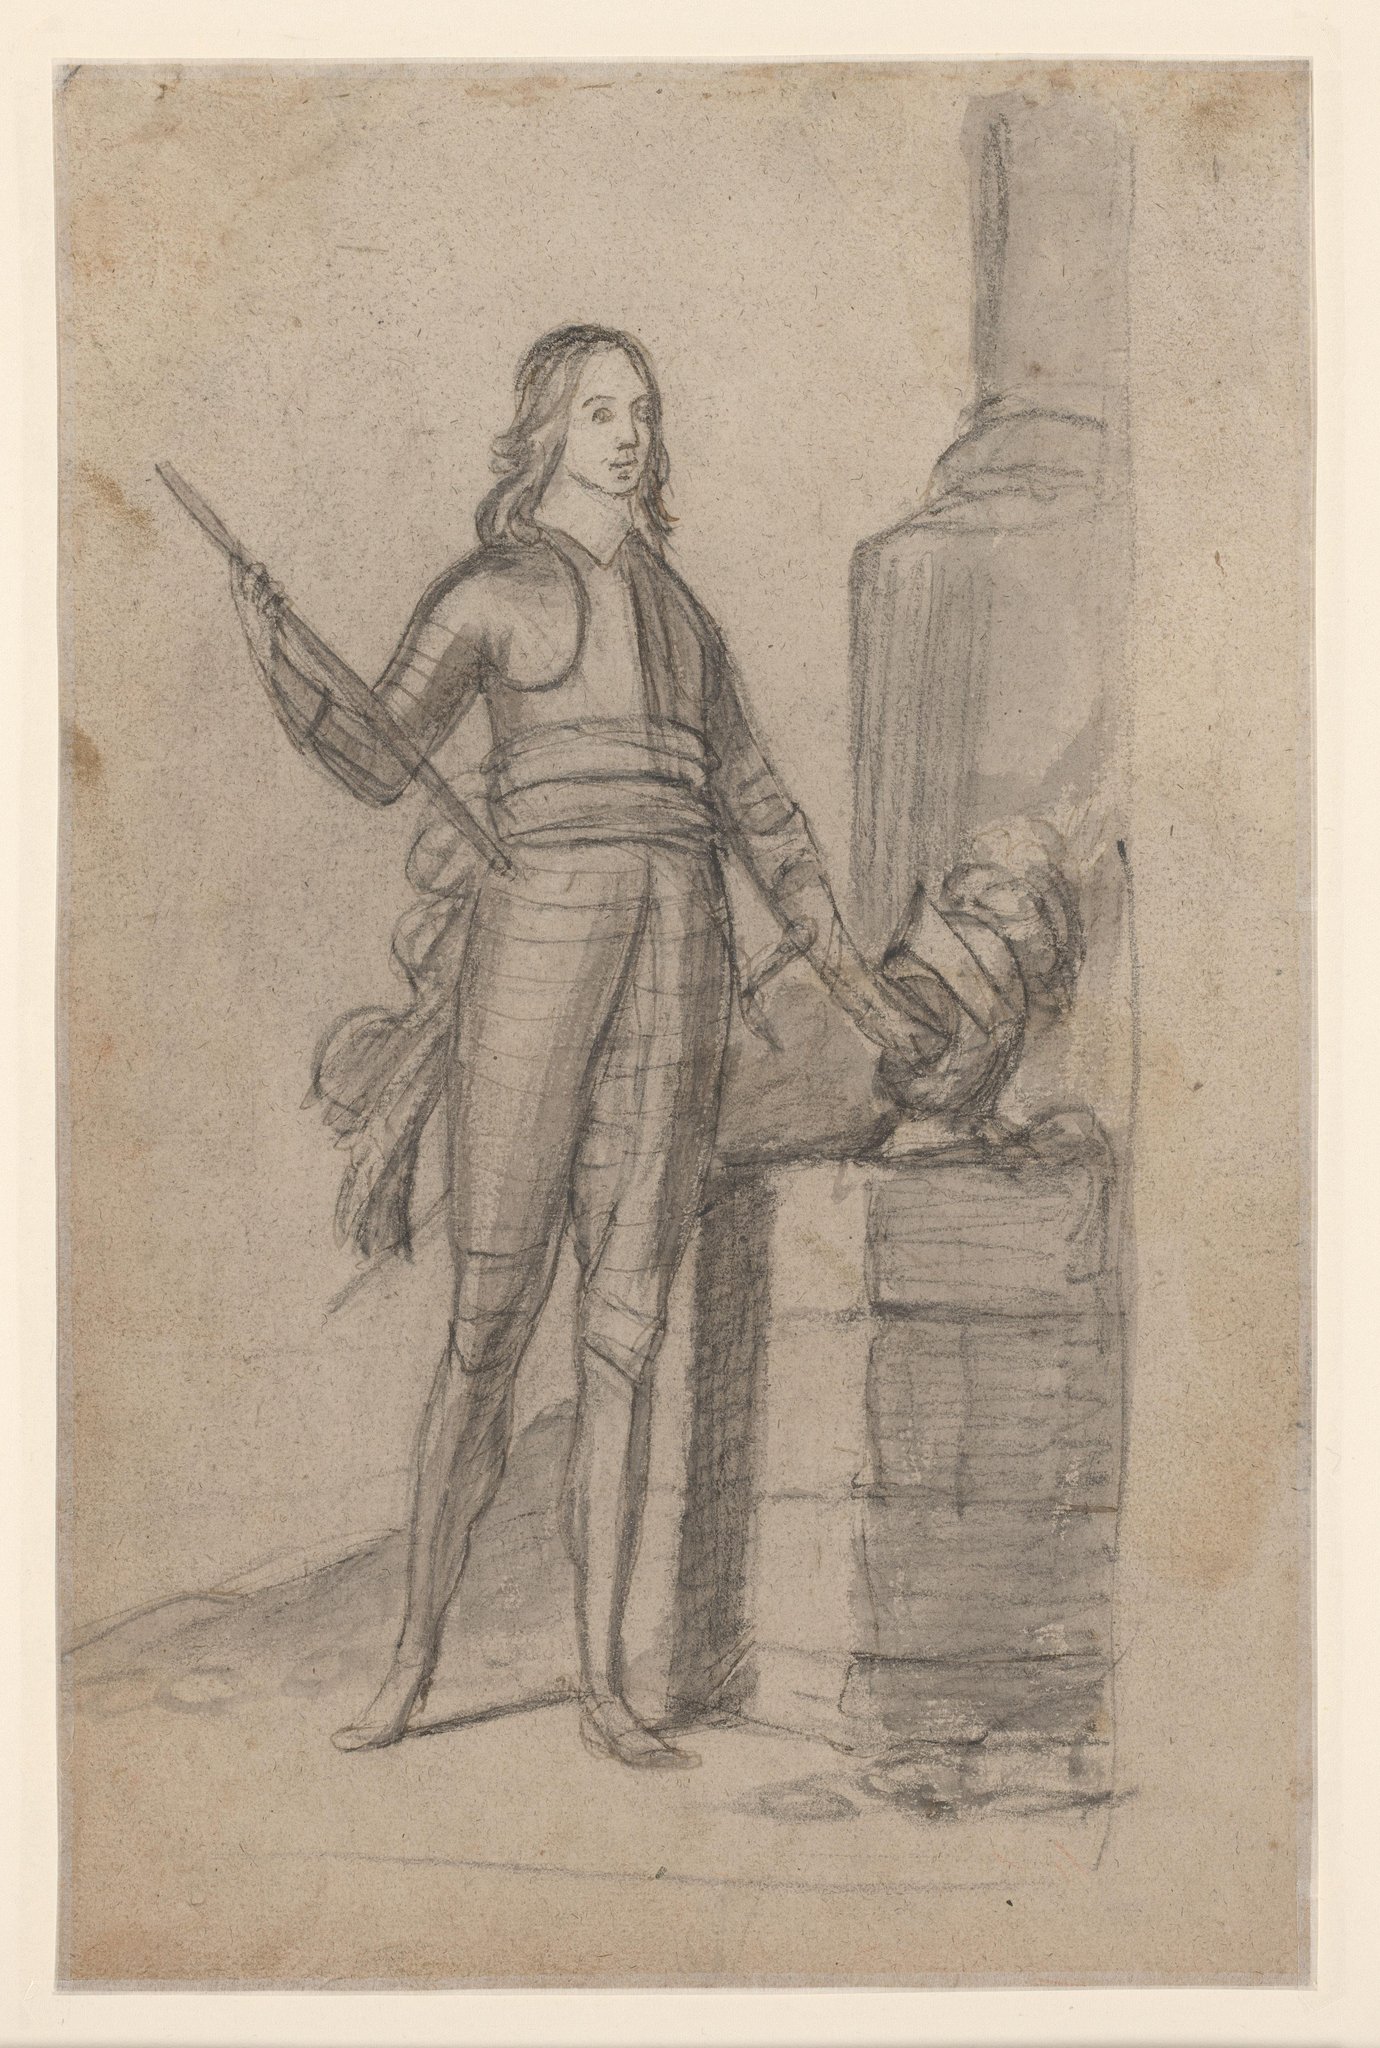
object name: drawing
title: Staande man in harnas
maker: gerard van honthorst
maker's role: draughtsman, painter, print maker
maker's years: 1592-1656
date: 1625-1655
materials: paper, chalk, ink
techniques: brush, pen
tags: historical persons not known by name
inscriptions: number: ‘No 30’